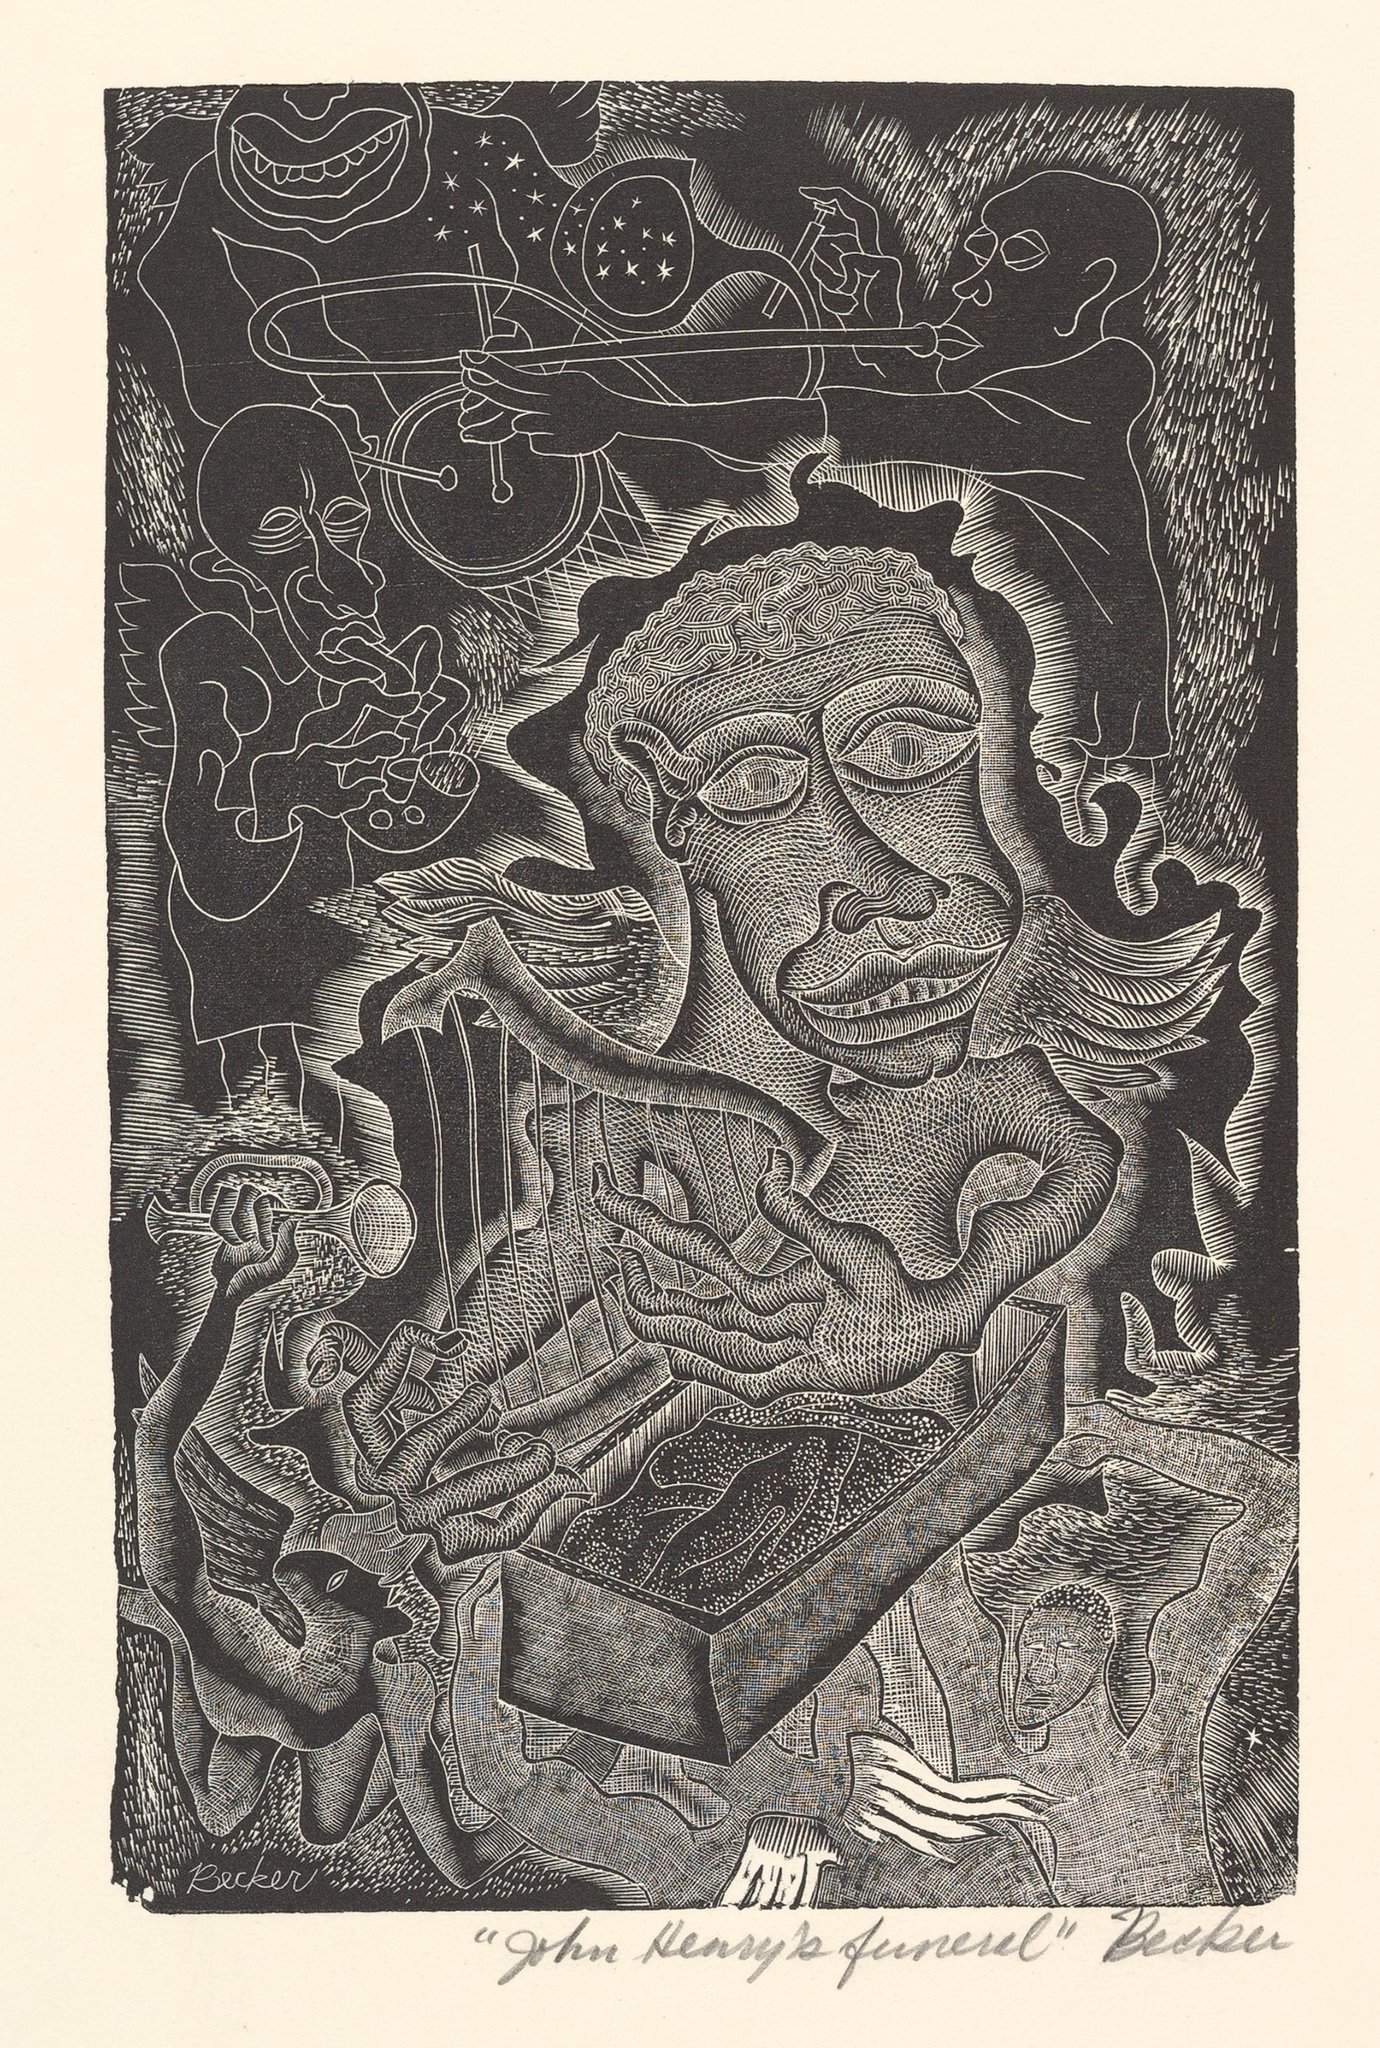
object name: print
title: John Henry's Funeral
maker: fred becker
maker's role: artist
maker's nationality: american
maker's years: 1913-2004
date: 1935-1940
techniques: engraving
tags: harps,trumpets,funerals